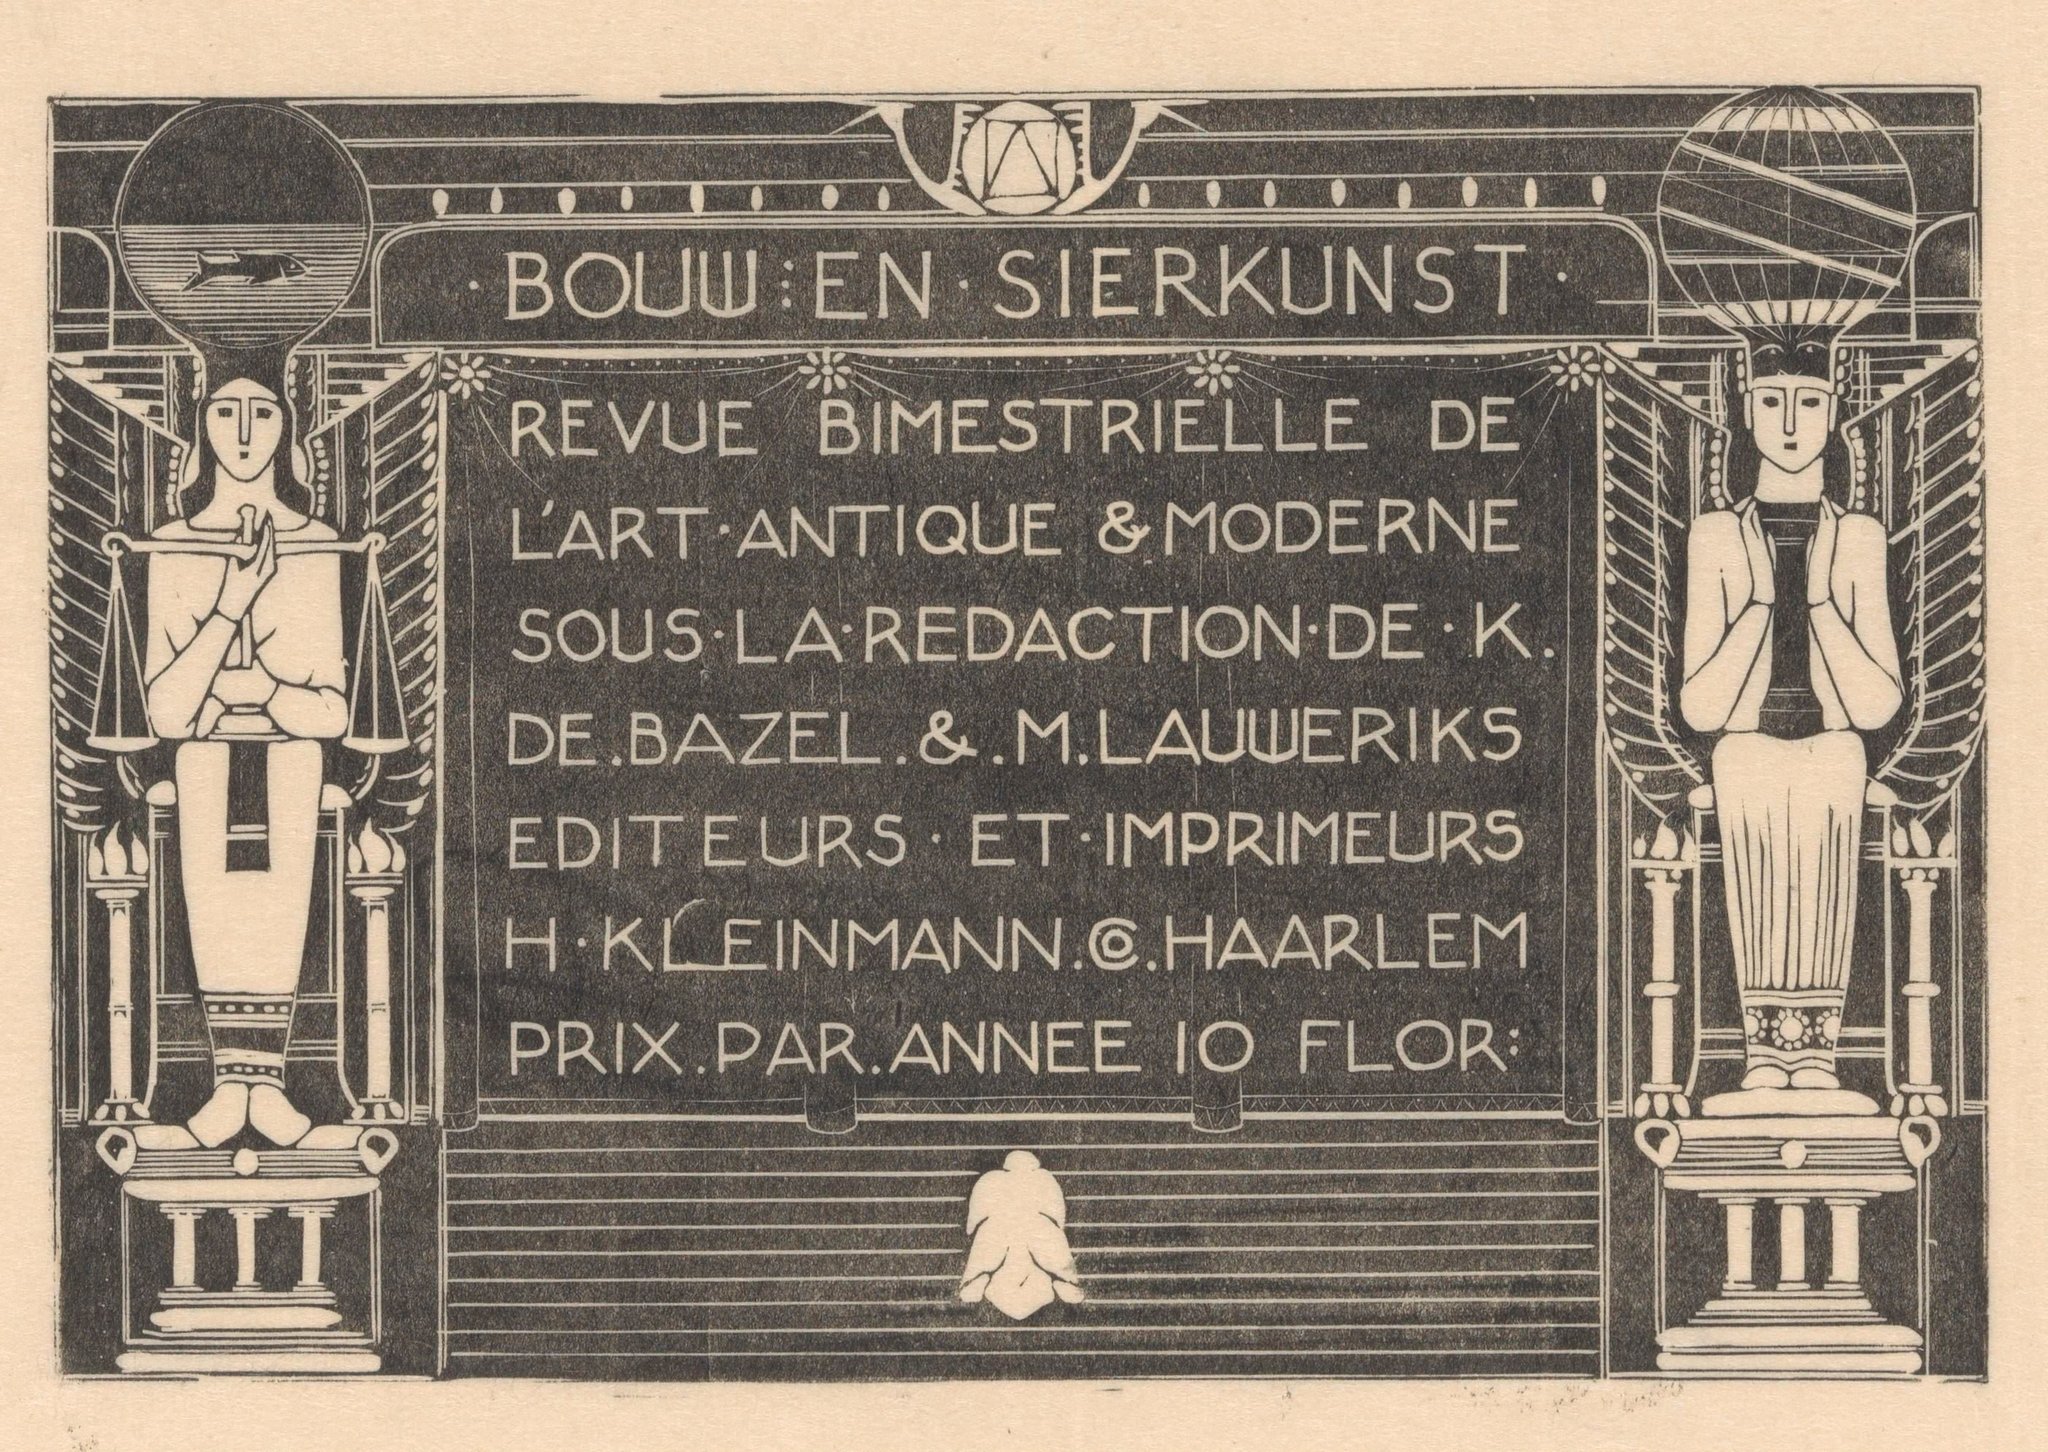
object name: advertising card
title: Reclamekaart voor 'Bouw- en sierkunst'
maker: mathieu lauweriks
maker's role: designer, draughtsman, print maker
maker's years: 1864-1932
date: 1898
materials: paper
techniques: woodcut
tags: caryatids ~ architecture, advertisement, notice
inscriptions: collector's mark: Lugt 2228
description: Reclamekaart voor het tijdschrift 'Bouw- en sierkunst' met twee kariatiden. De linker heeft een weegschaal vast; de rechter een zuil.